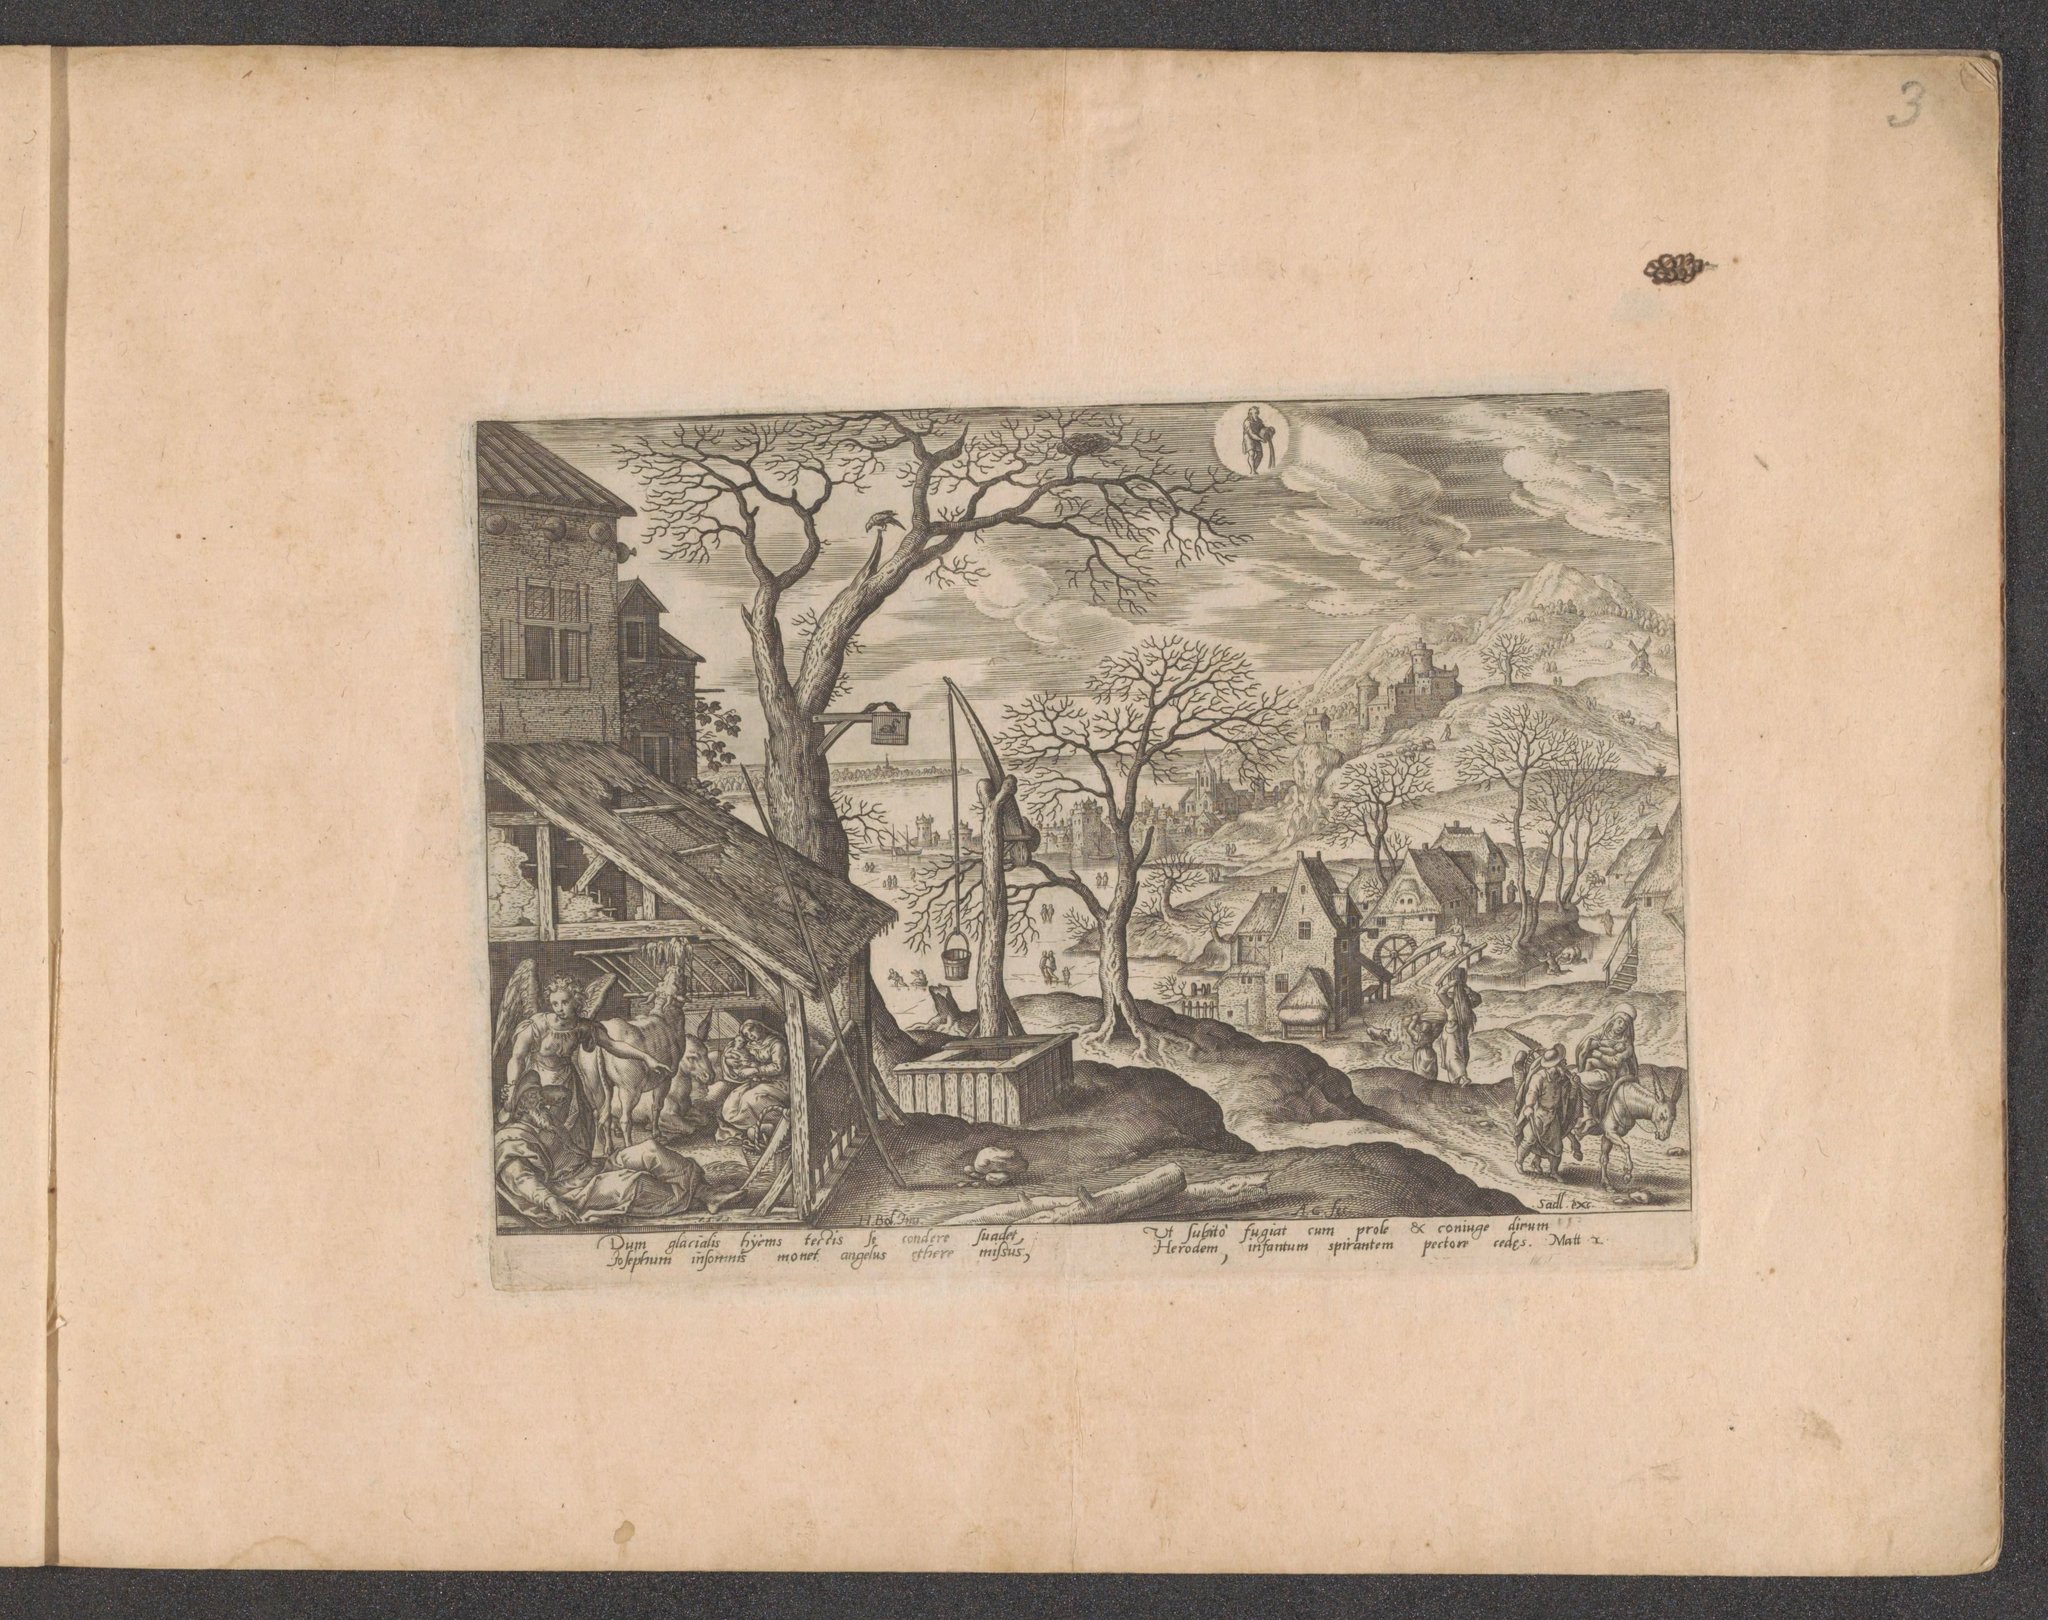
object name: album leaf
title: Emblemata Evangelica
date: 1585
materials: paper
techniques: engraving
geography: antwerp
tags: flight into egypt and miracles during the journey, an angel appearing to joseph in a dream summons him to flee into egypt, aquarius (zodiacal sign of january), landscape symbolizing january, mary, joseph and the new-born christ (nativity)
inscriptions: date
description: Middenboven het teken van de dierenriem Waterman. In de linkeronderhoek de stal waar Jozef en zijn gezin liggen te slapen. Jozef wordt door een engel gewekt en gewaarschuwd voor de plannen van Herodes. In de rechteronderhoek vertrekt het gezin naar Egypte. Winters heuvellanschap op de achtergrond. Onder de voorstelling vier regels Latijn in twee kolommen (Mat. 2). De prent maakt deel uit van een album.